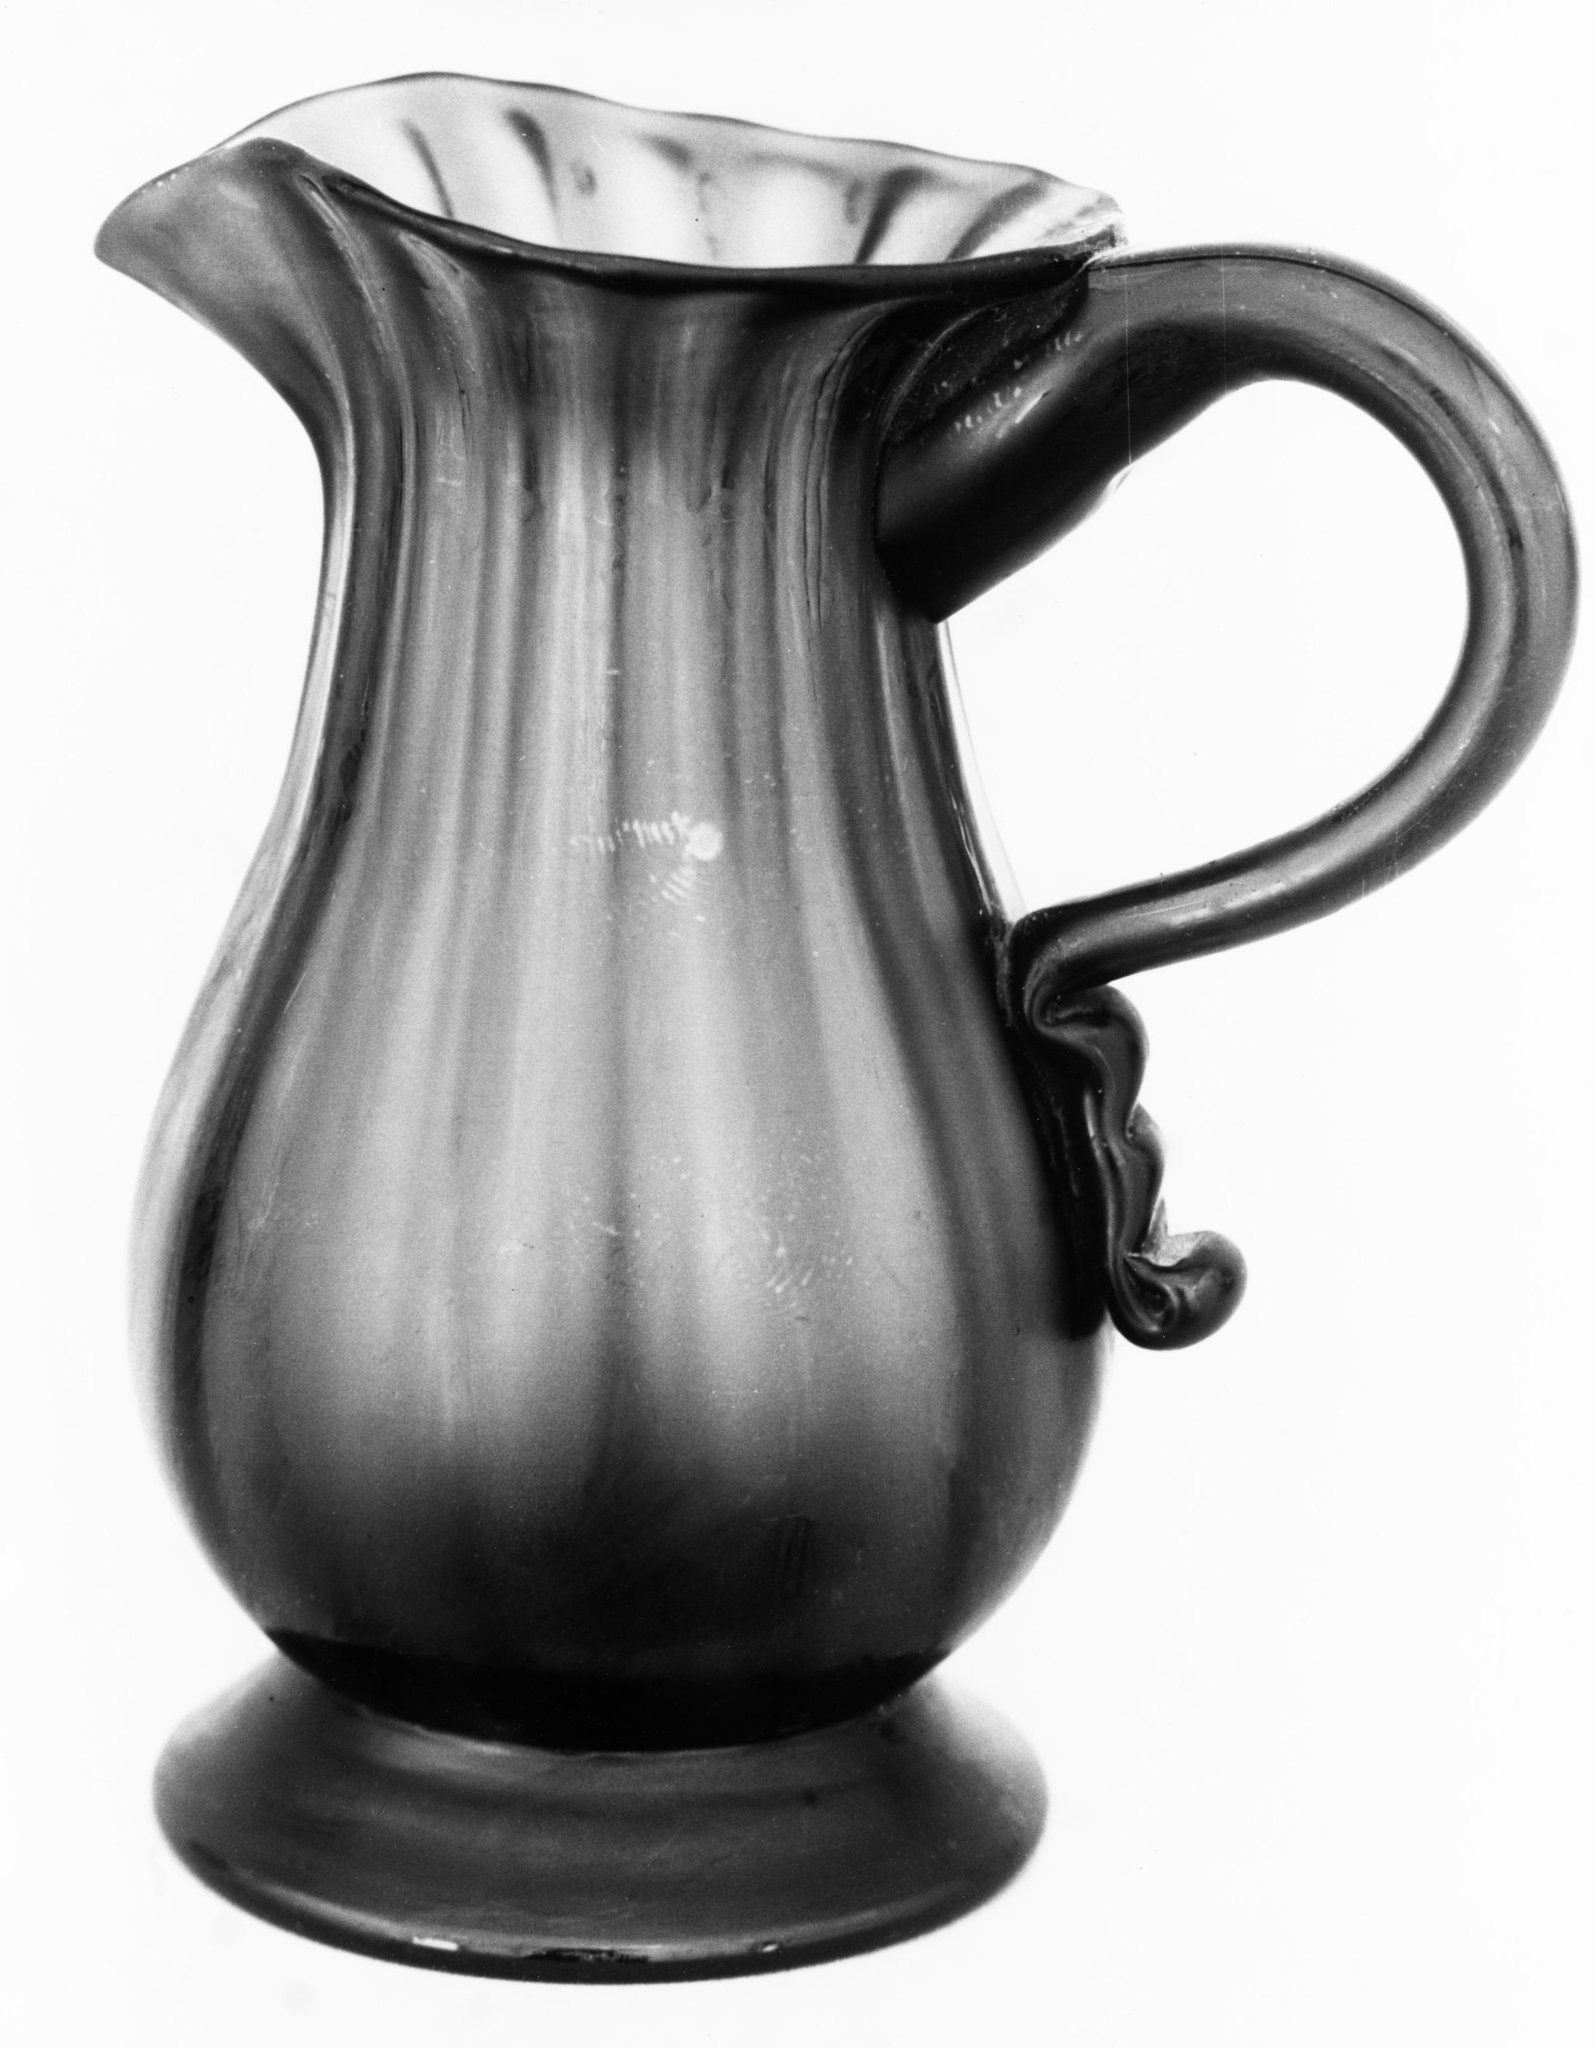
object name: cream pot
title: Creamer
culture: american or british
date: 1780-1820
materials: glass, lead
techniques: glassblowing, molding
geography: england